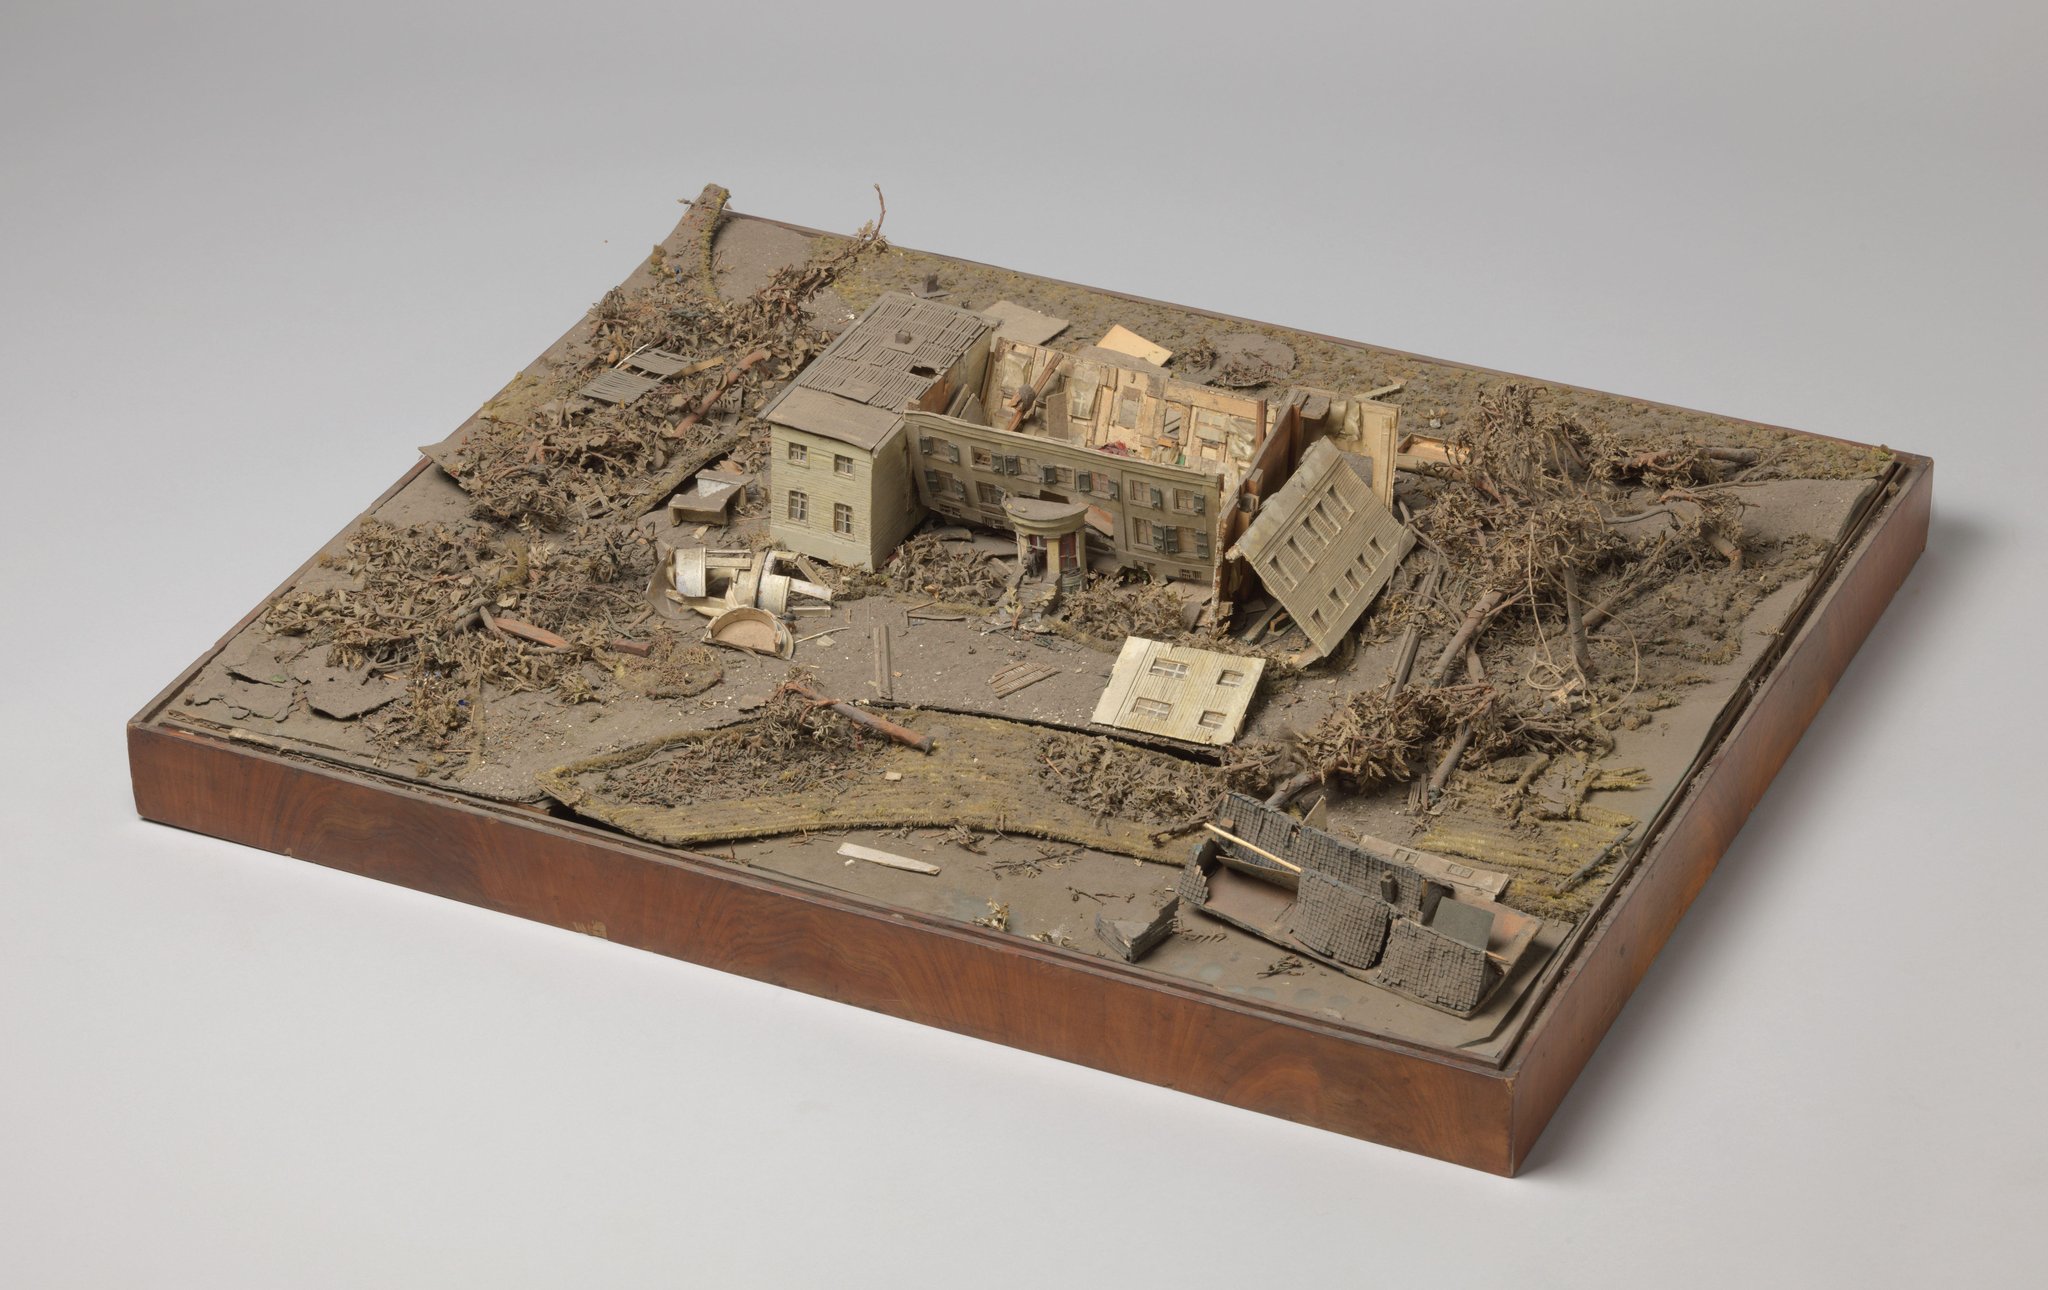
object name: model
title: Een model van het huis de Pauw bij 's-Gravenhage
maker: Anonymous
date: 1800-1999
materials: textile, paper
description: Een model van papier in chenille, onder glas op een mahoniehouten tafel, van het huis de Pauw bij 's-Gravenhage.